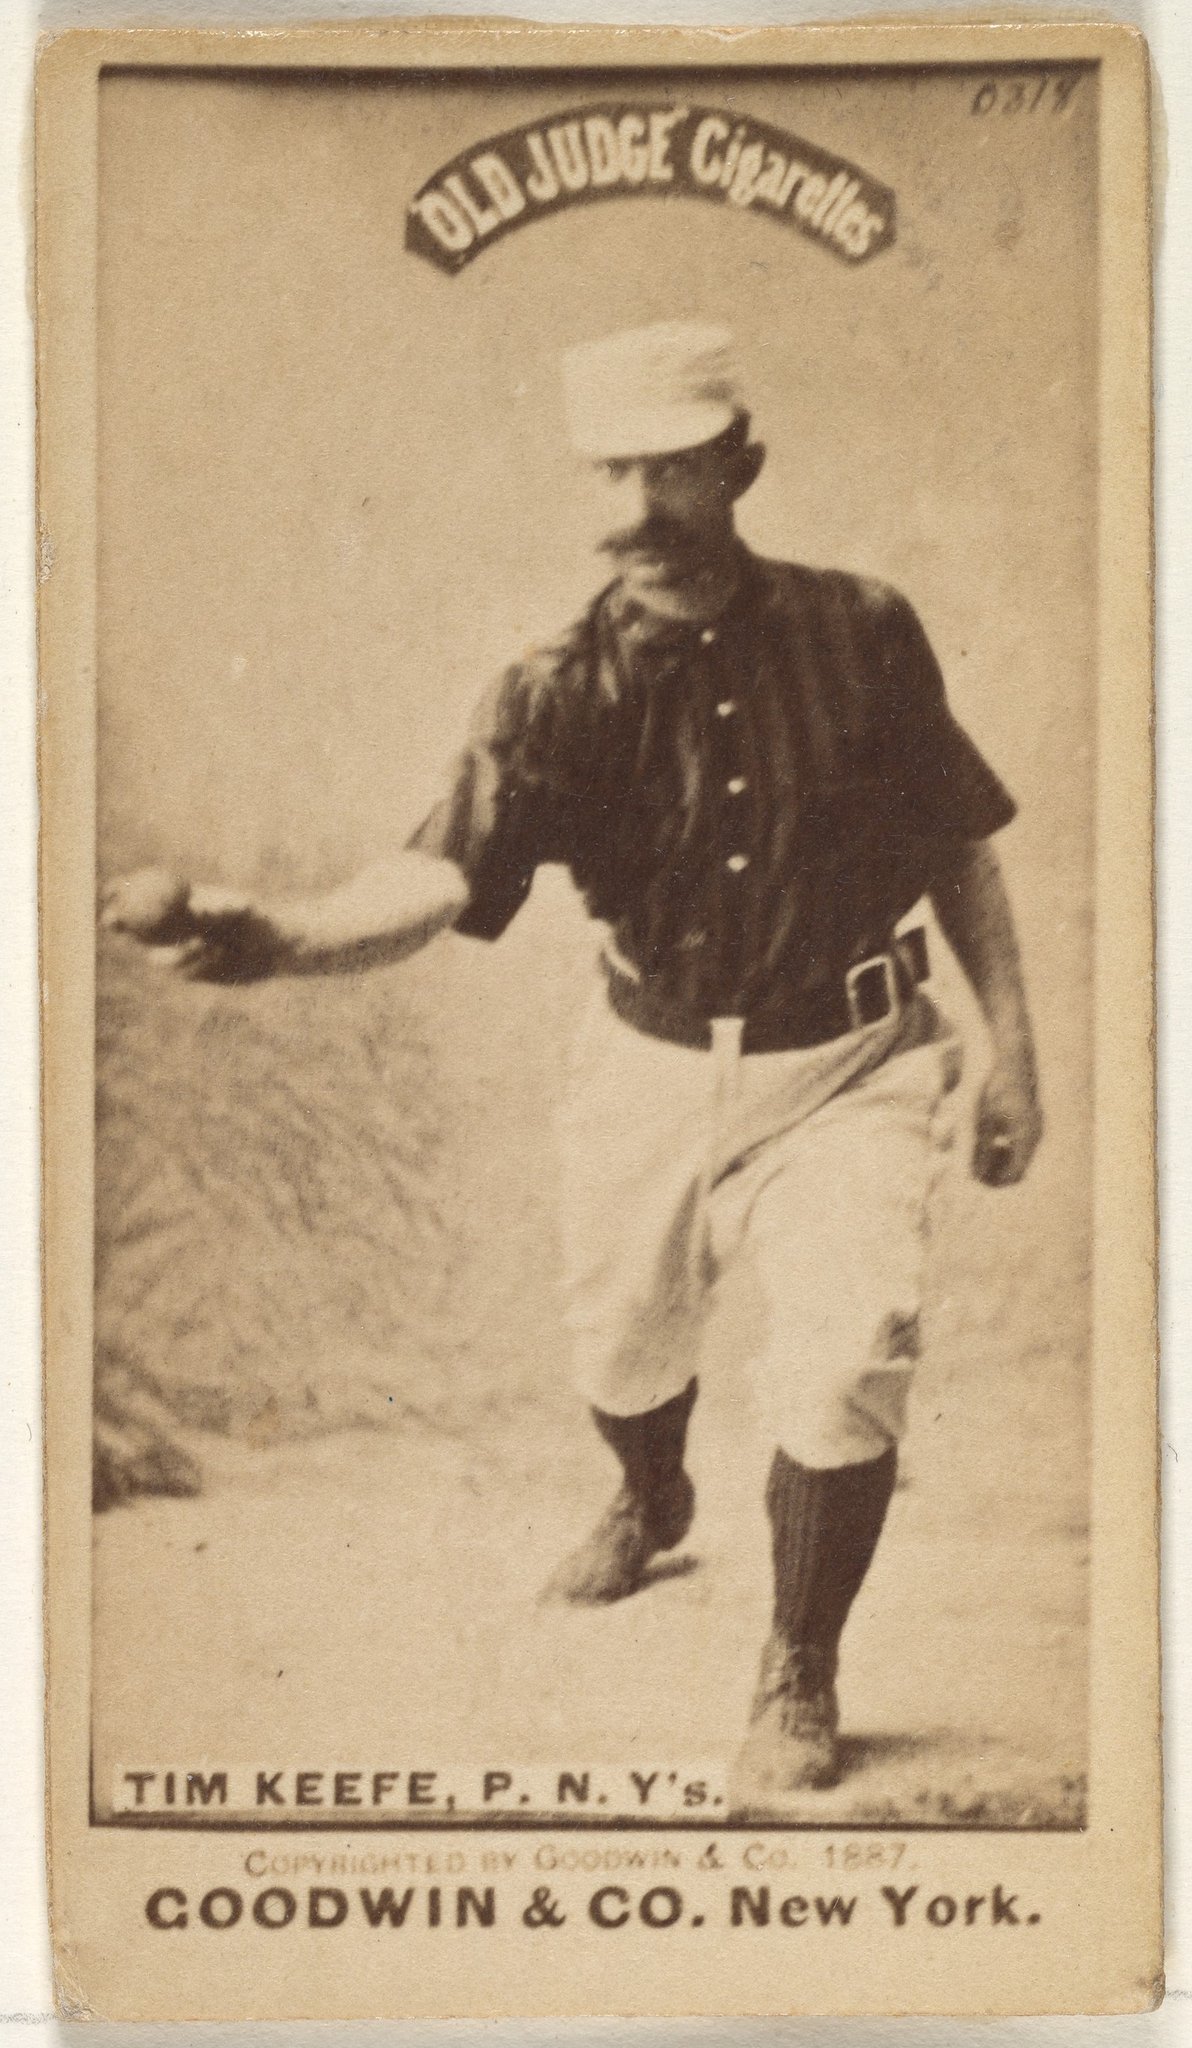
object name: baseball card, photograph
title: Timothy John "Tim" Keefe, Pitcher, New York, from the Old Judge series (N172) for Old Judge Cigarettes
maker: goodwin & company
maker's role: publisher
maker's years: 1850-1950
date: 1887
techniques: albumen silver print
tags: men,portraits,baseball,athletes